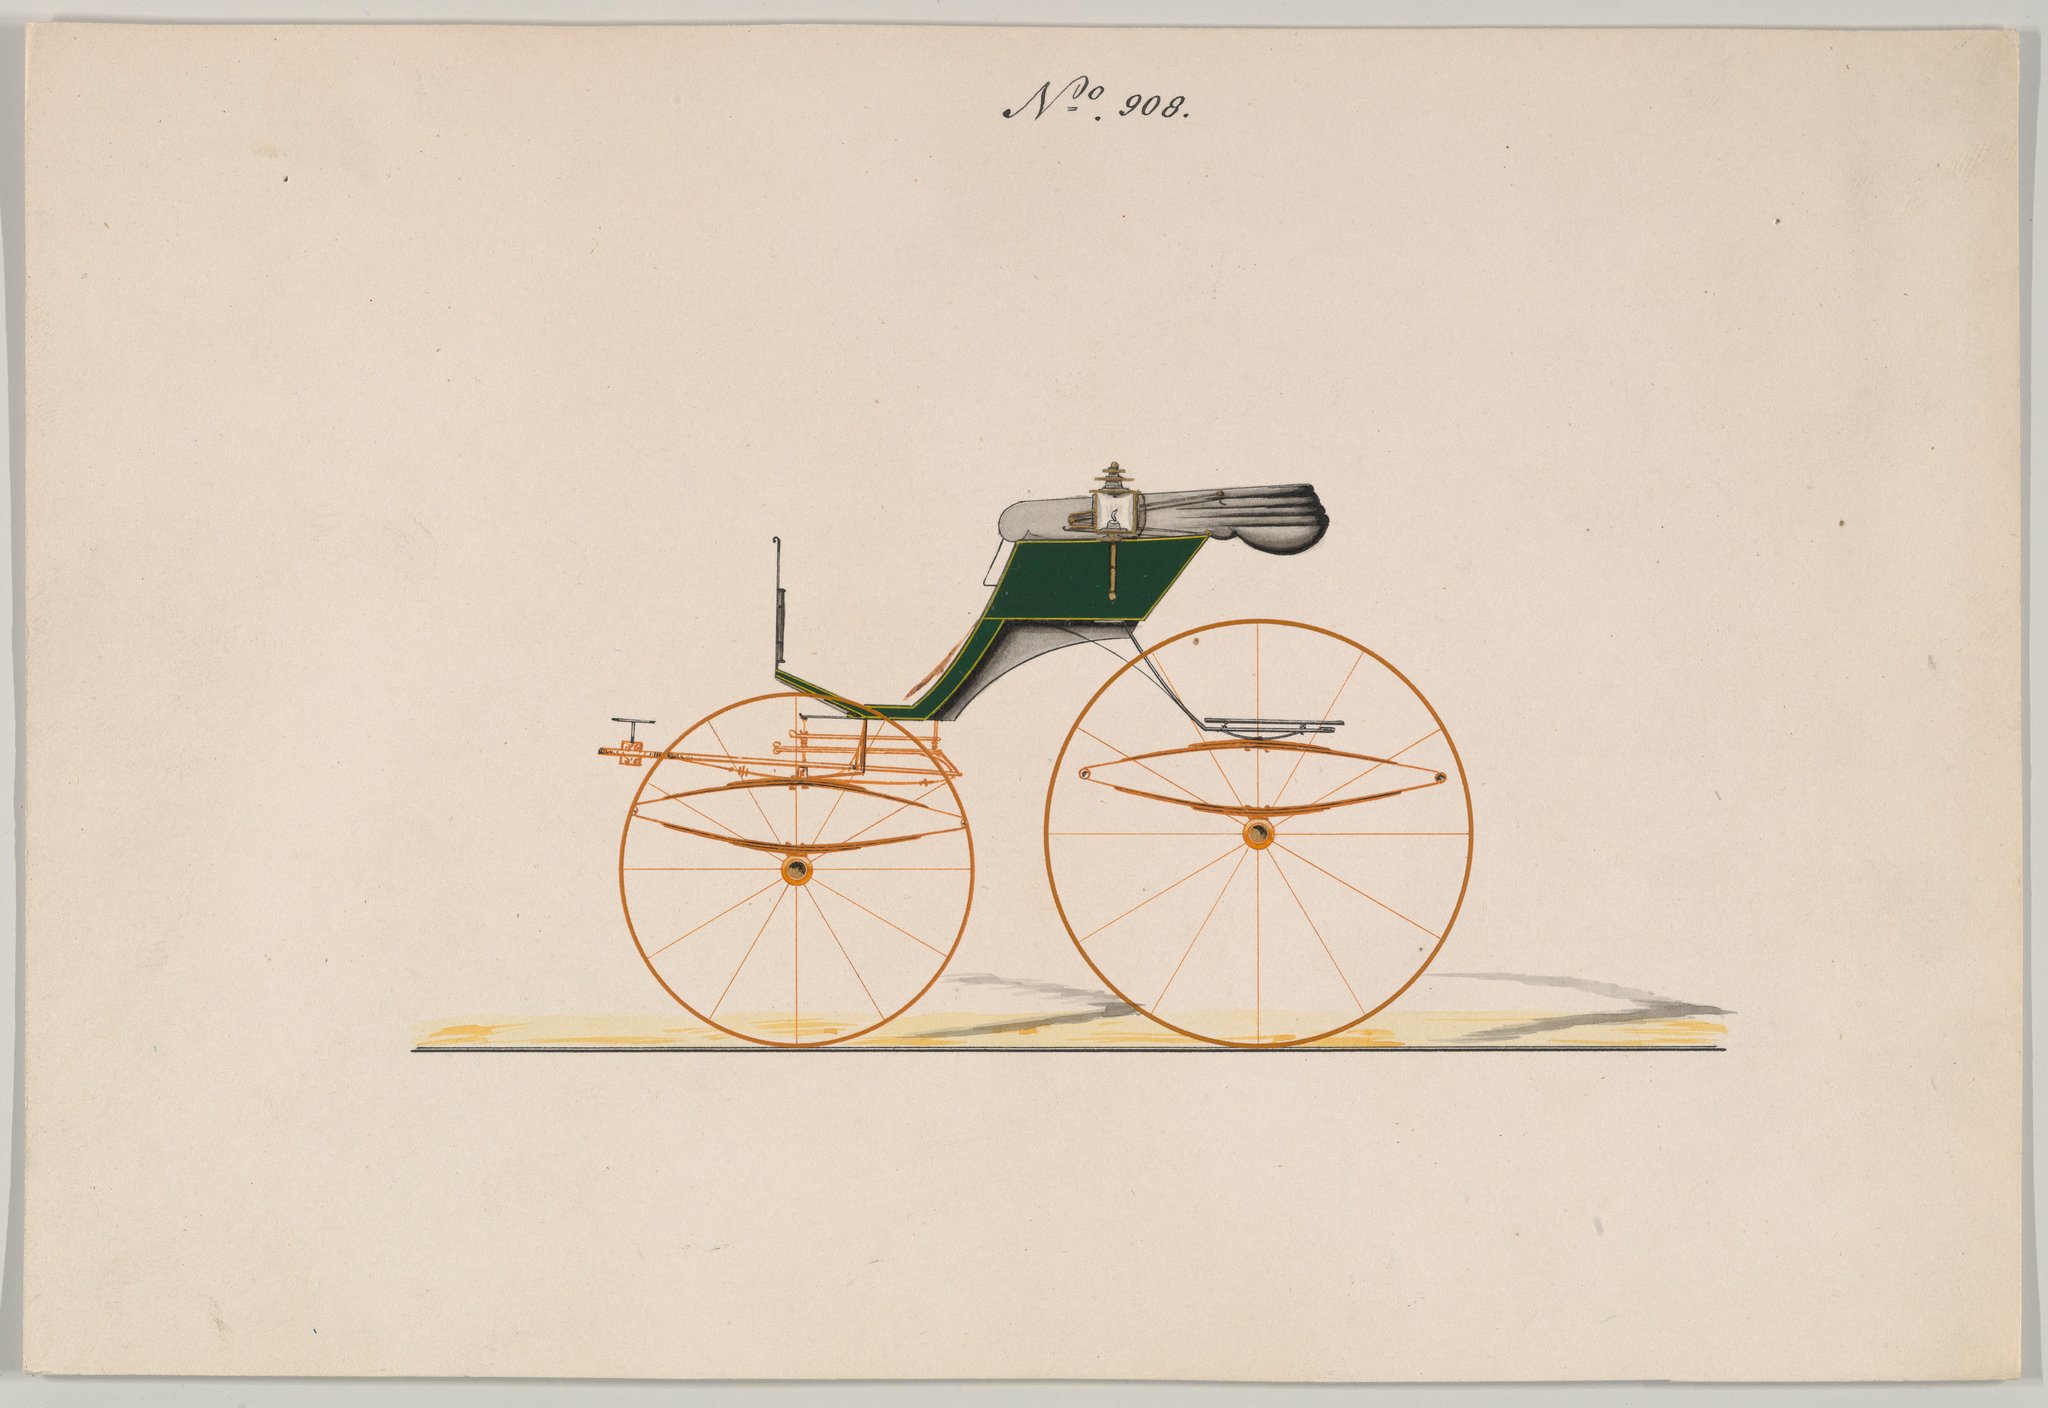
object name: drawing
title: Design for Unclassified Carriage, no. 908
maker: brewster & co.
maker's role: manufacturer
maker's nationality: american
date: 1850-1870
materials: gouache, gum arabic, ink, watercolor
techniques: pen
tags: carriages